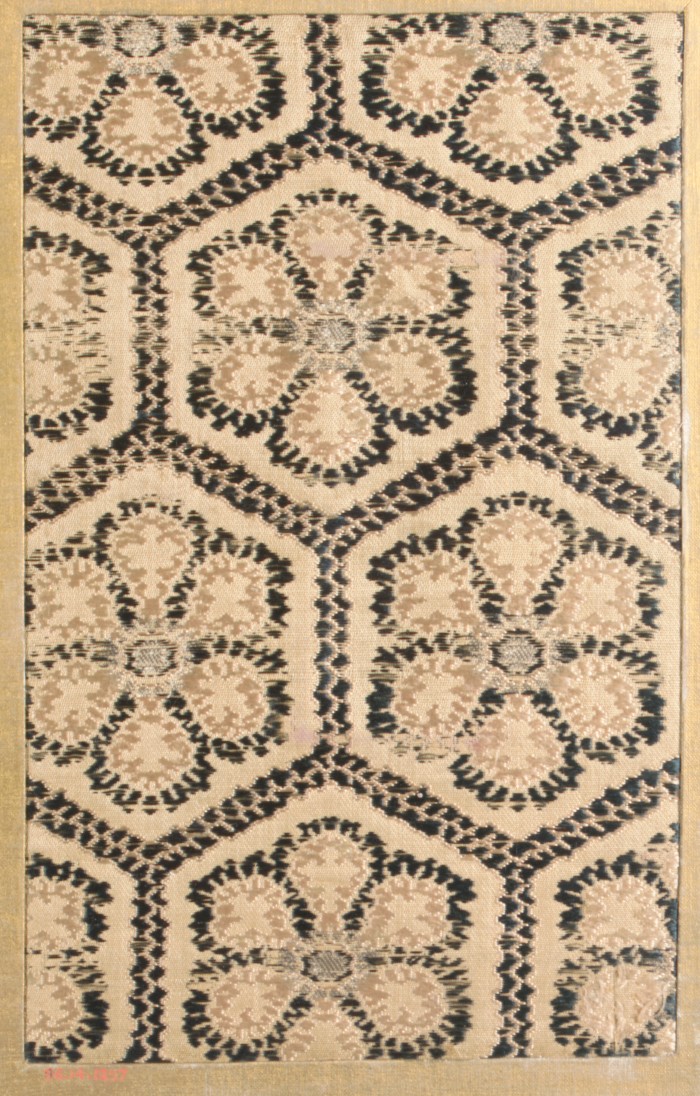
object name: piece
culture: japanese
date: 1701-1900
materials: silk